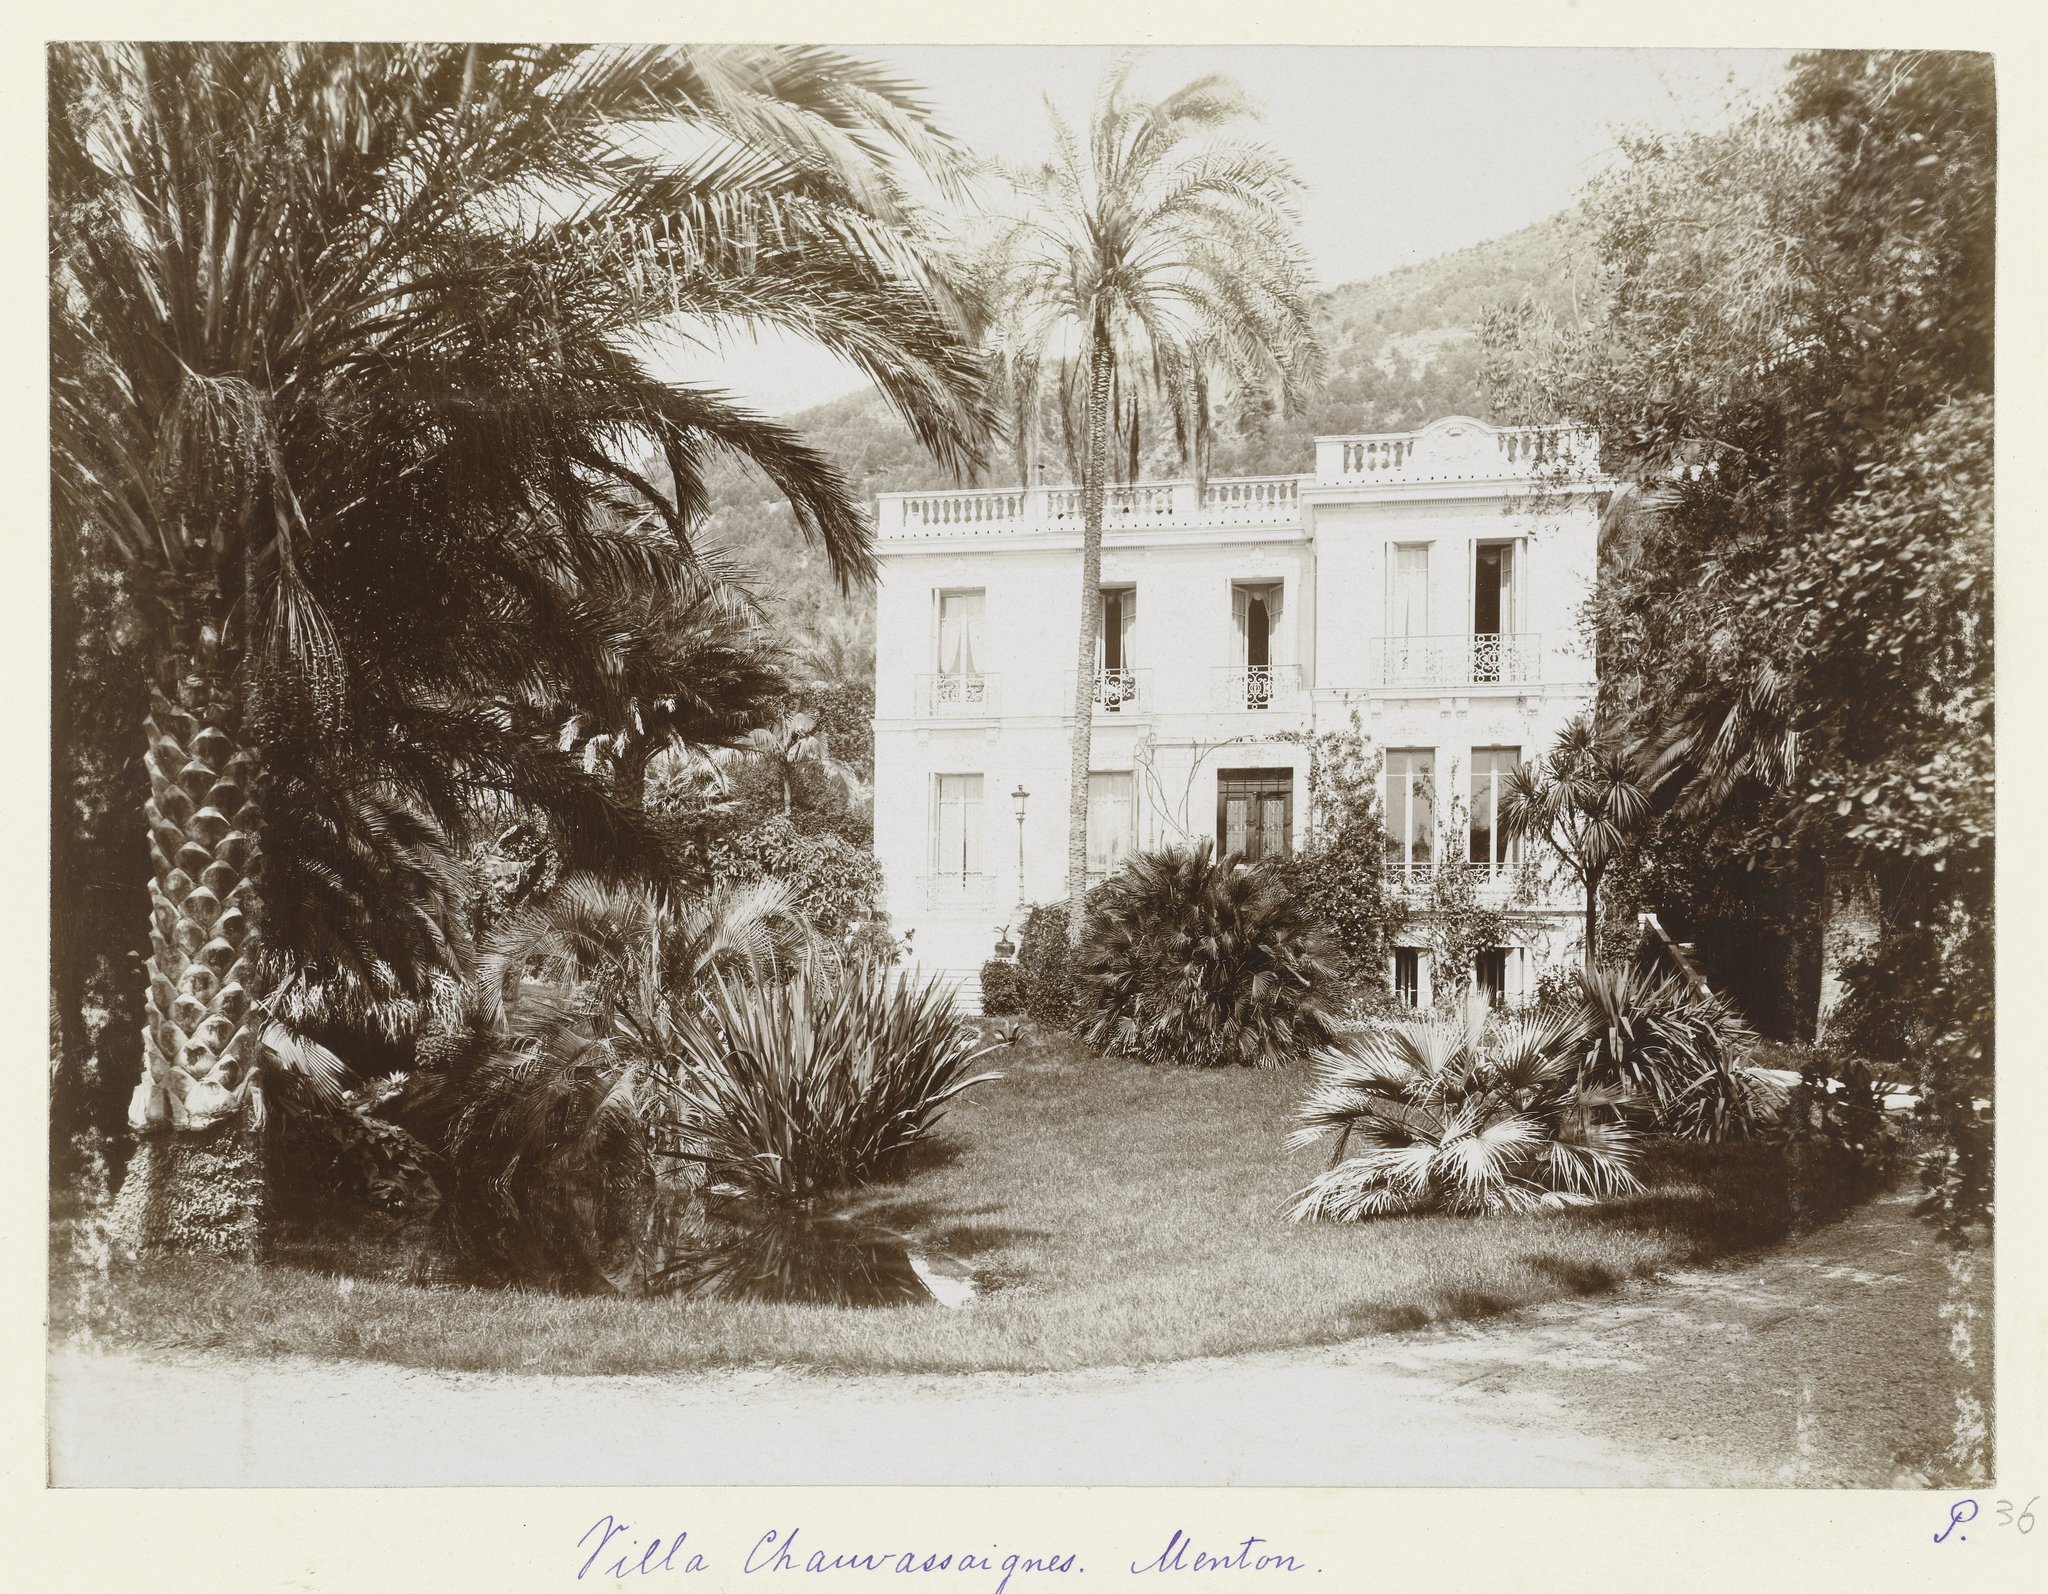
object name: photograph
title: Villa Chauvassaignes Menton.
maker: henry pauw van wieldrecht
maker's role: fotograaf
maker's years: 1863-1912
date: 1886-1896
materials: cardboard, photographic support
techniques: albumen print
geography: france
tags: menton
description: Villa Chauvassaignes met de bijbehorende tuin waar veel palmen in staan.